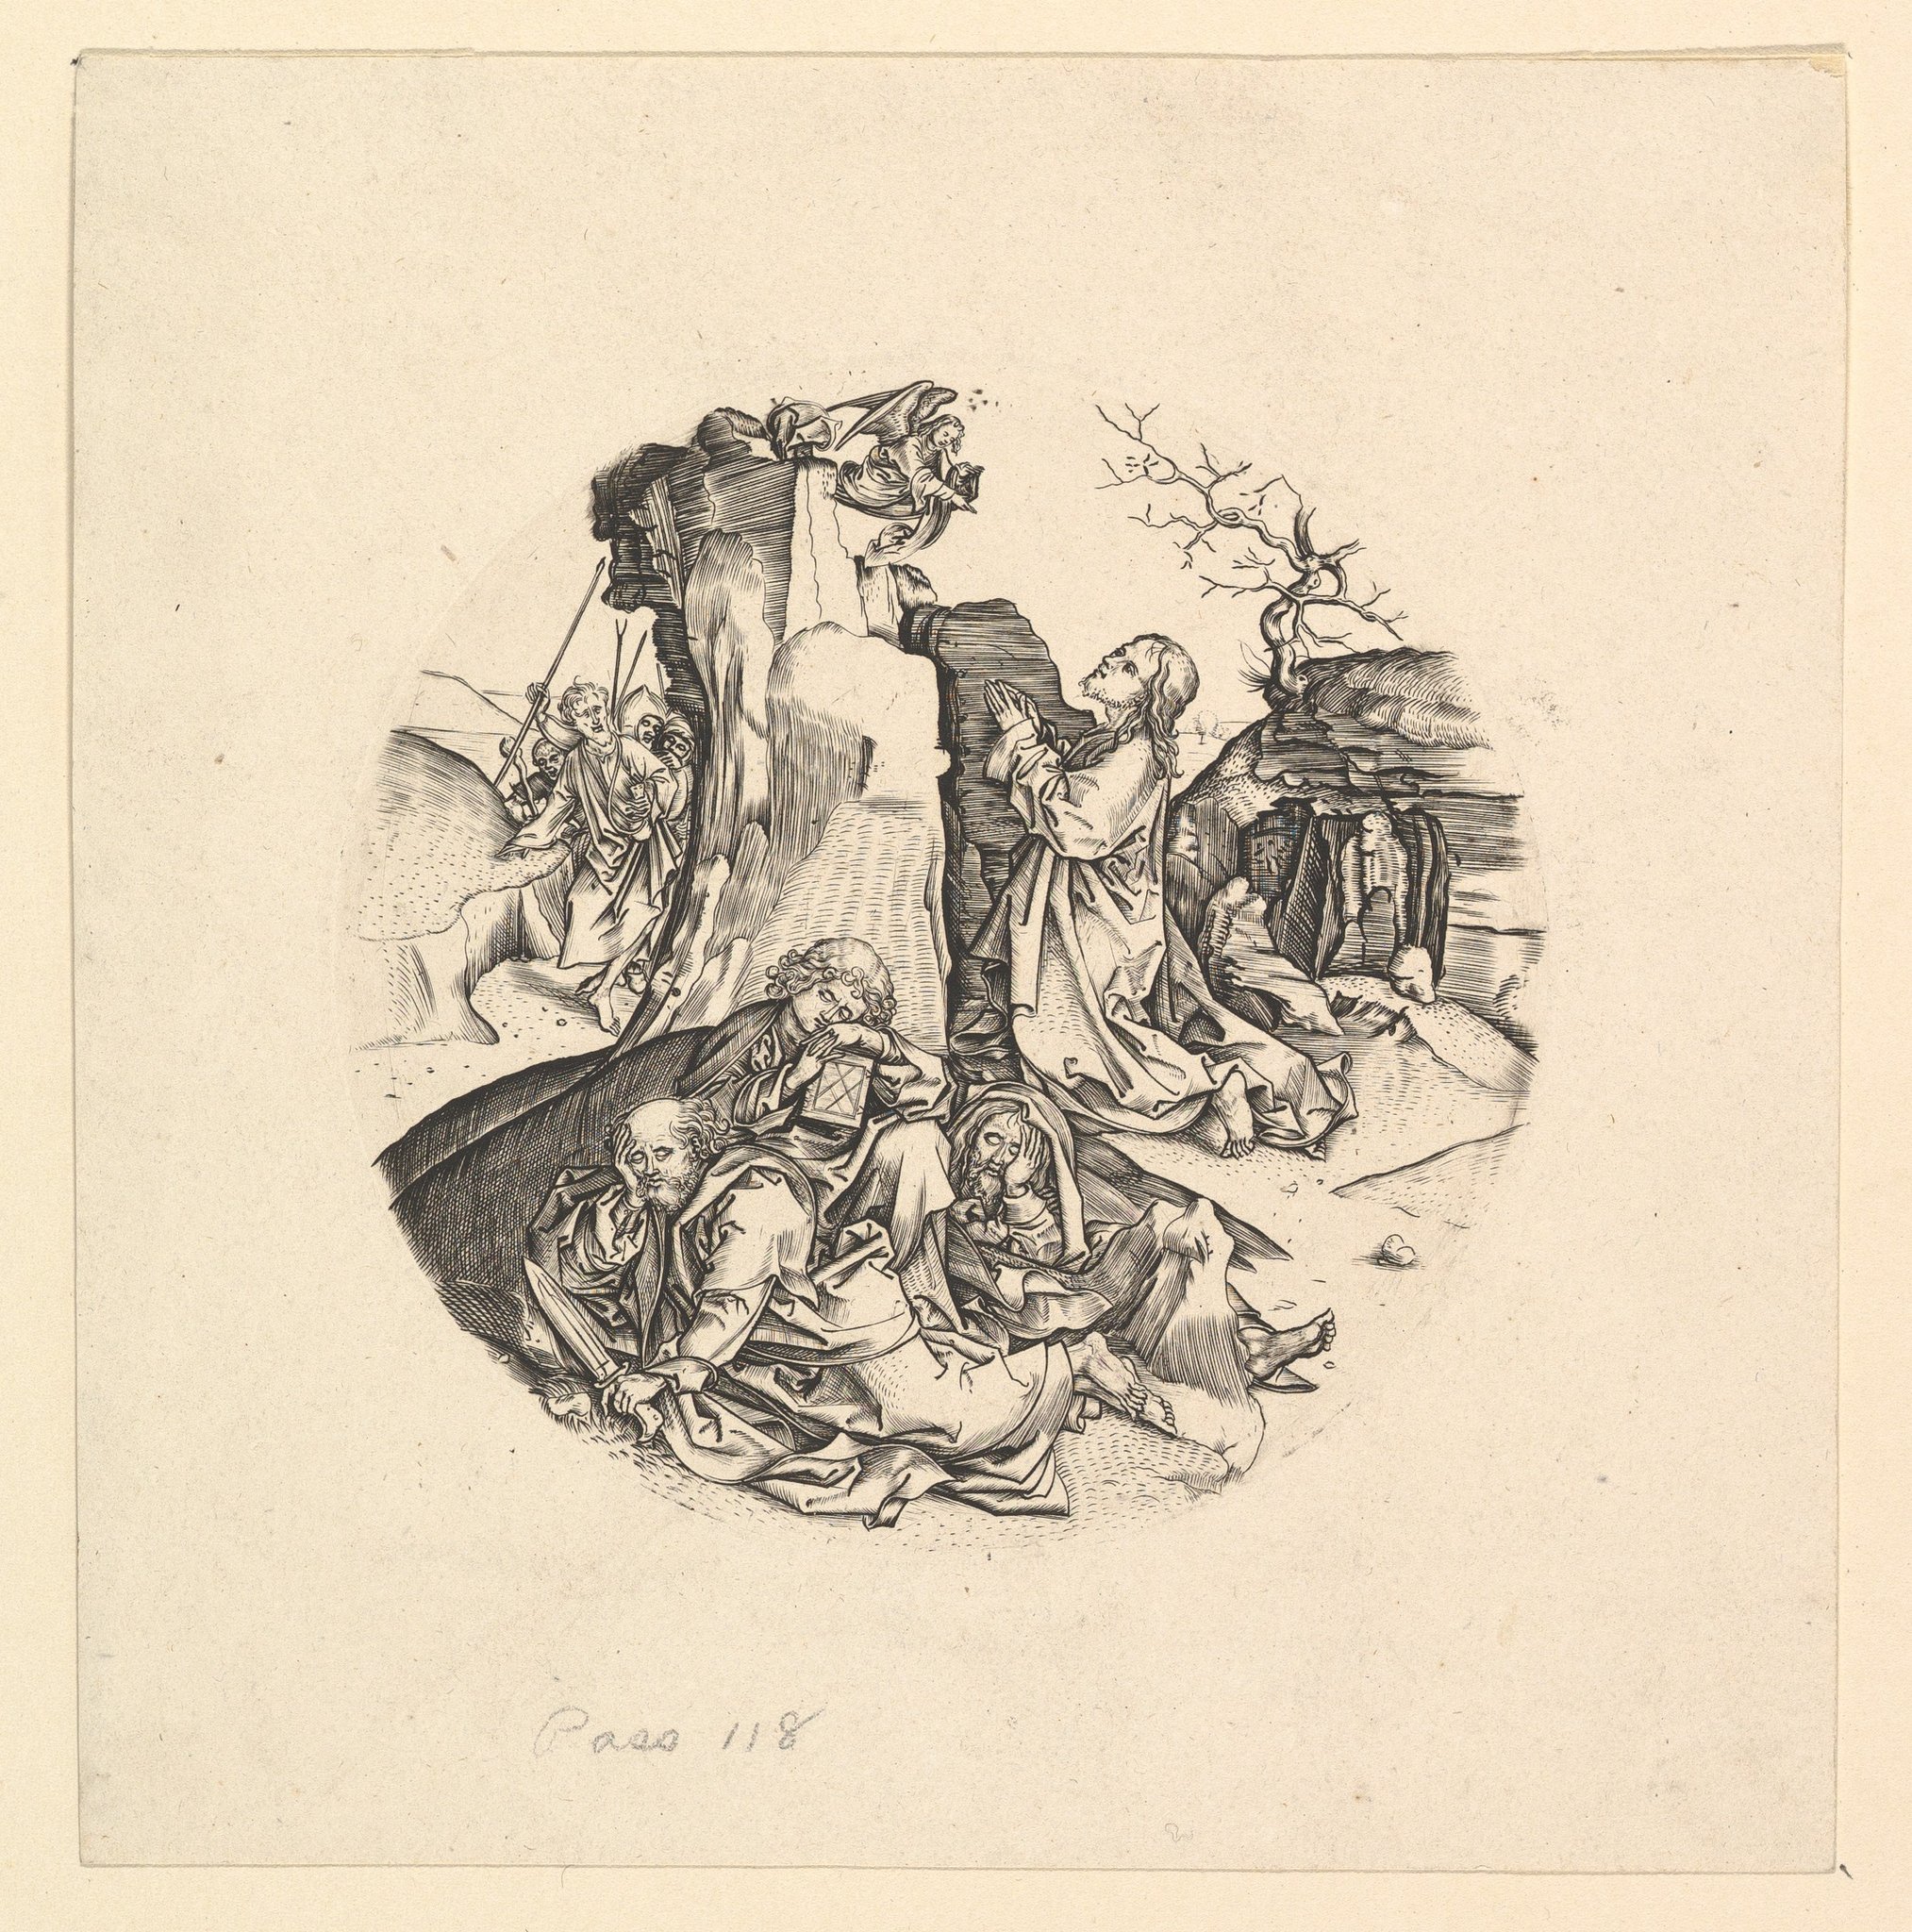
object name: print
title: Christ on the Mount of Olives (reverse copy in roundel)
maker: martin schongauer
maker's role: artist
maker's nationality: german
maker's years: 1430-1491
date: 1467-1600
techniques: engraving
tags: suffering,men,angels,christ,praying